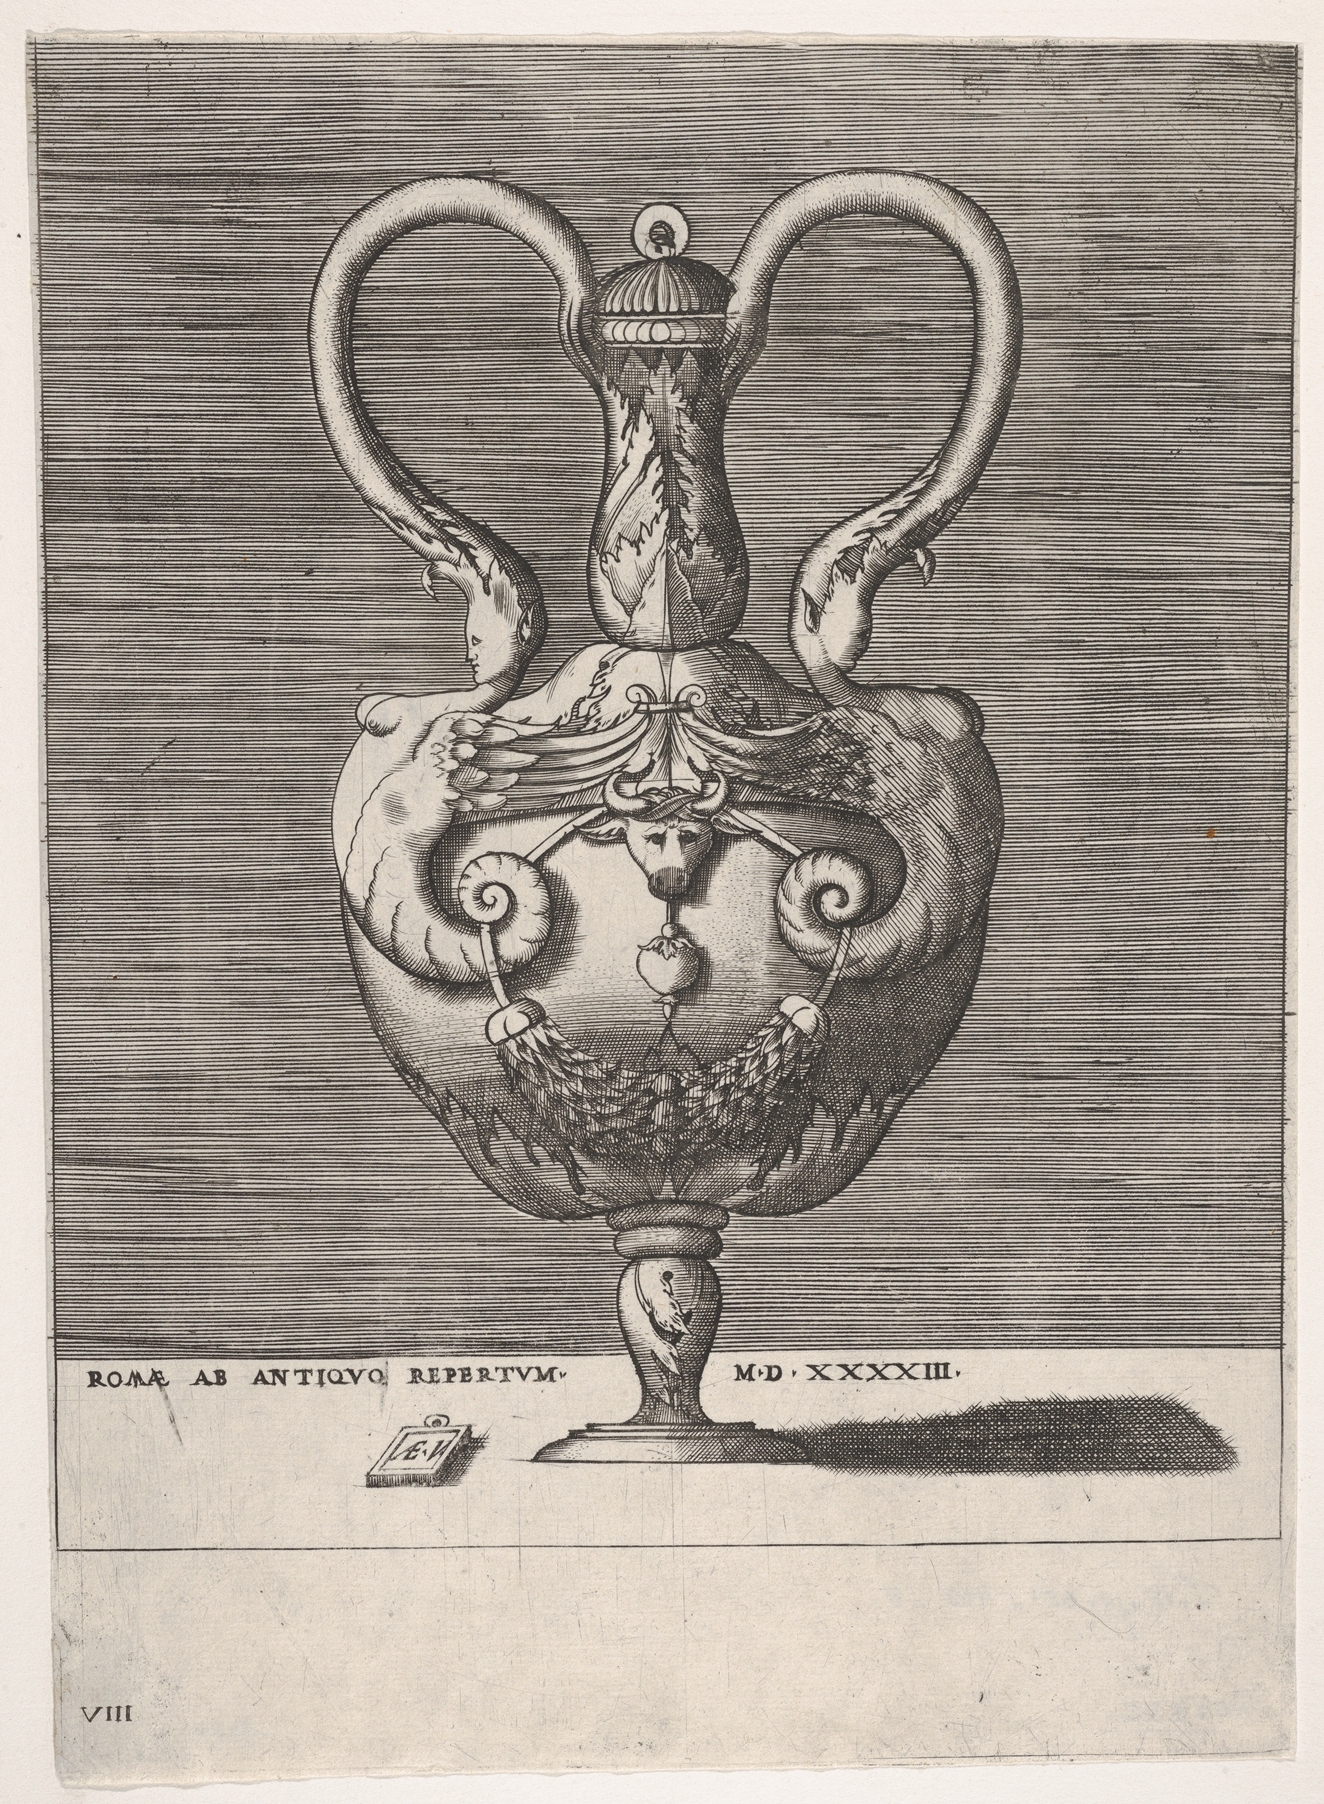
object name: print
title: Antique Lidded Vase with Two Handles emerging from the Heads of Hybrid Female Sphinxes, from "Vases after the Antique"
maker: enea vico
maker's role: artist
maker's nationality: italian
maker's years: 1523-1567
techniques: engraving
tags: animals,garlands,vases